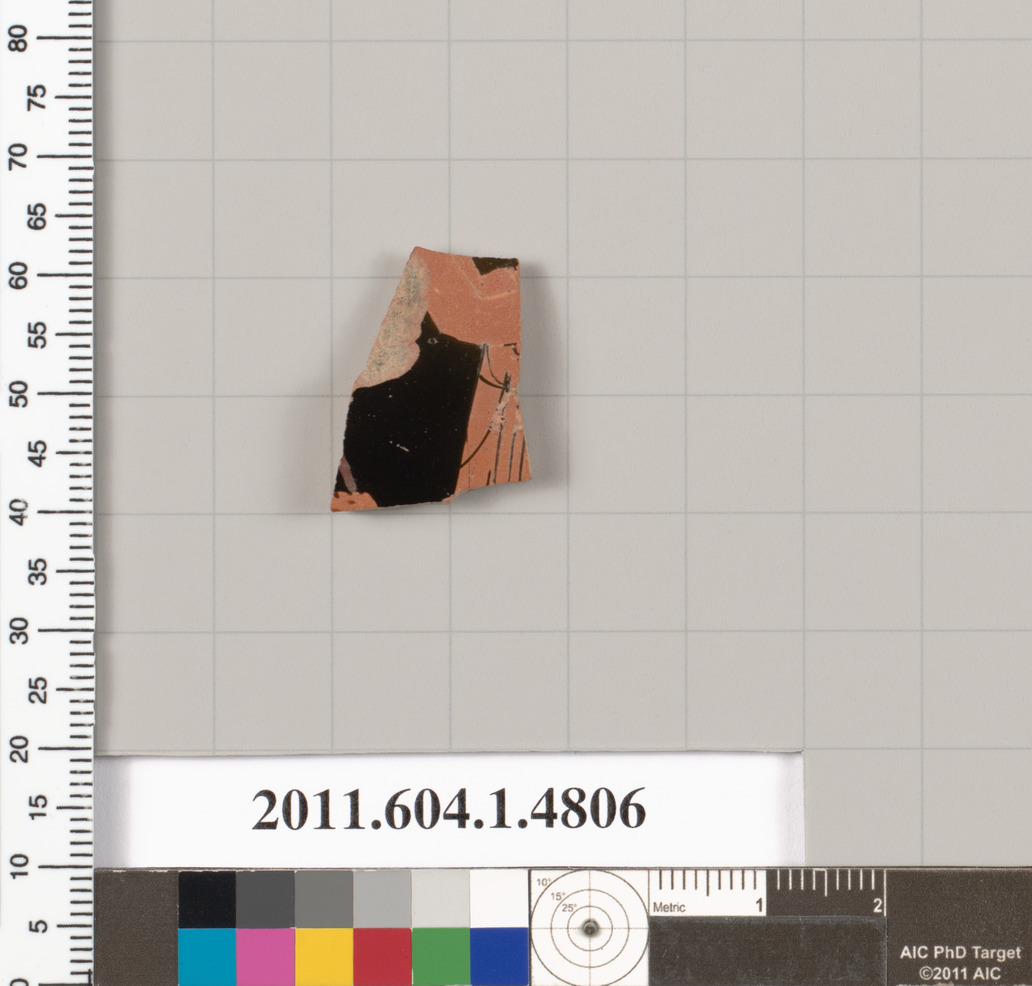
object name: kylix fragment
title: Terracotta fragment of a kylix (drinking cup)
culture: greek, attic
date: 480-470 BCE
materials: terracotta